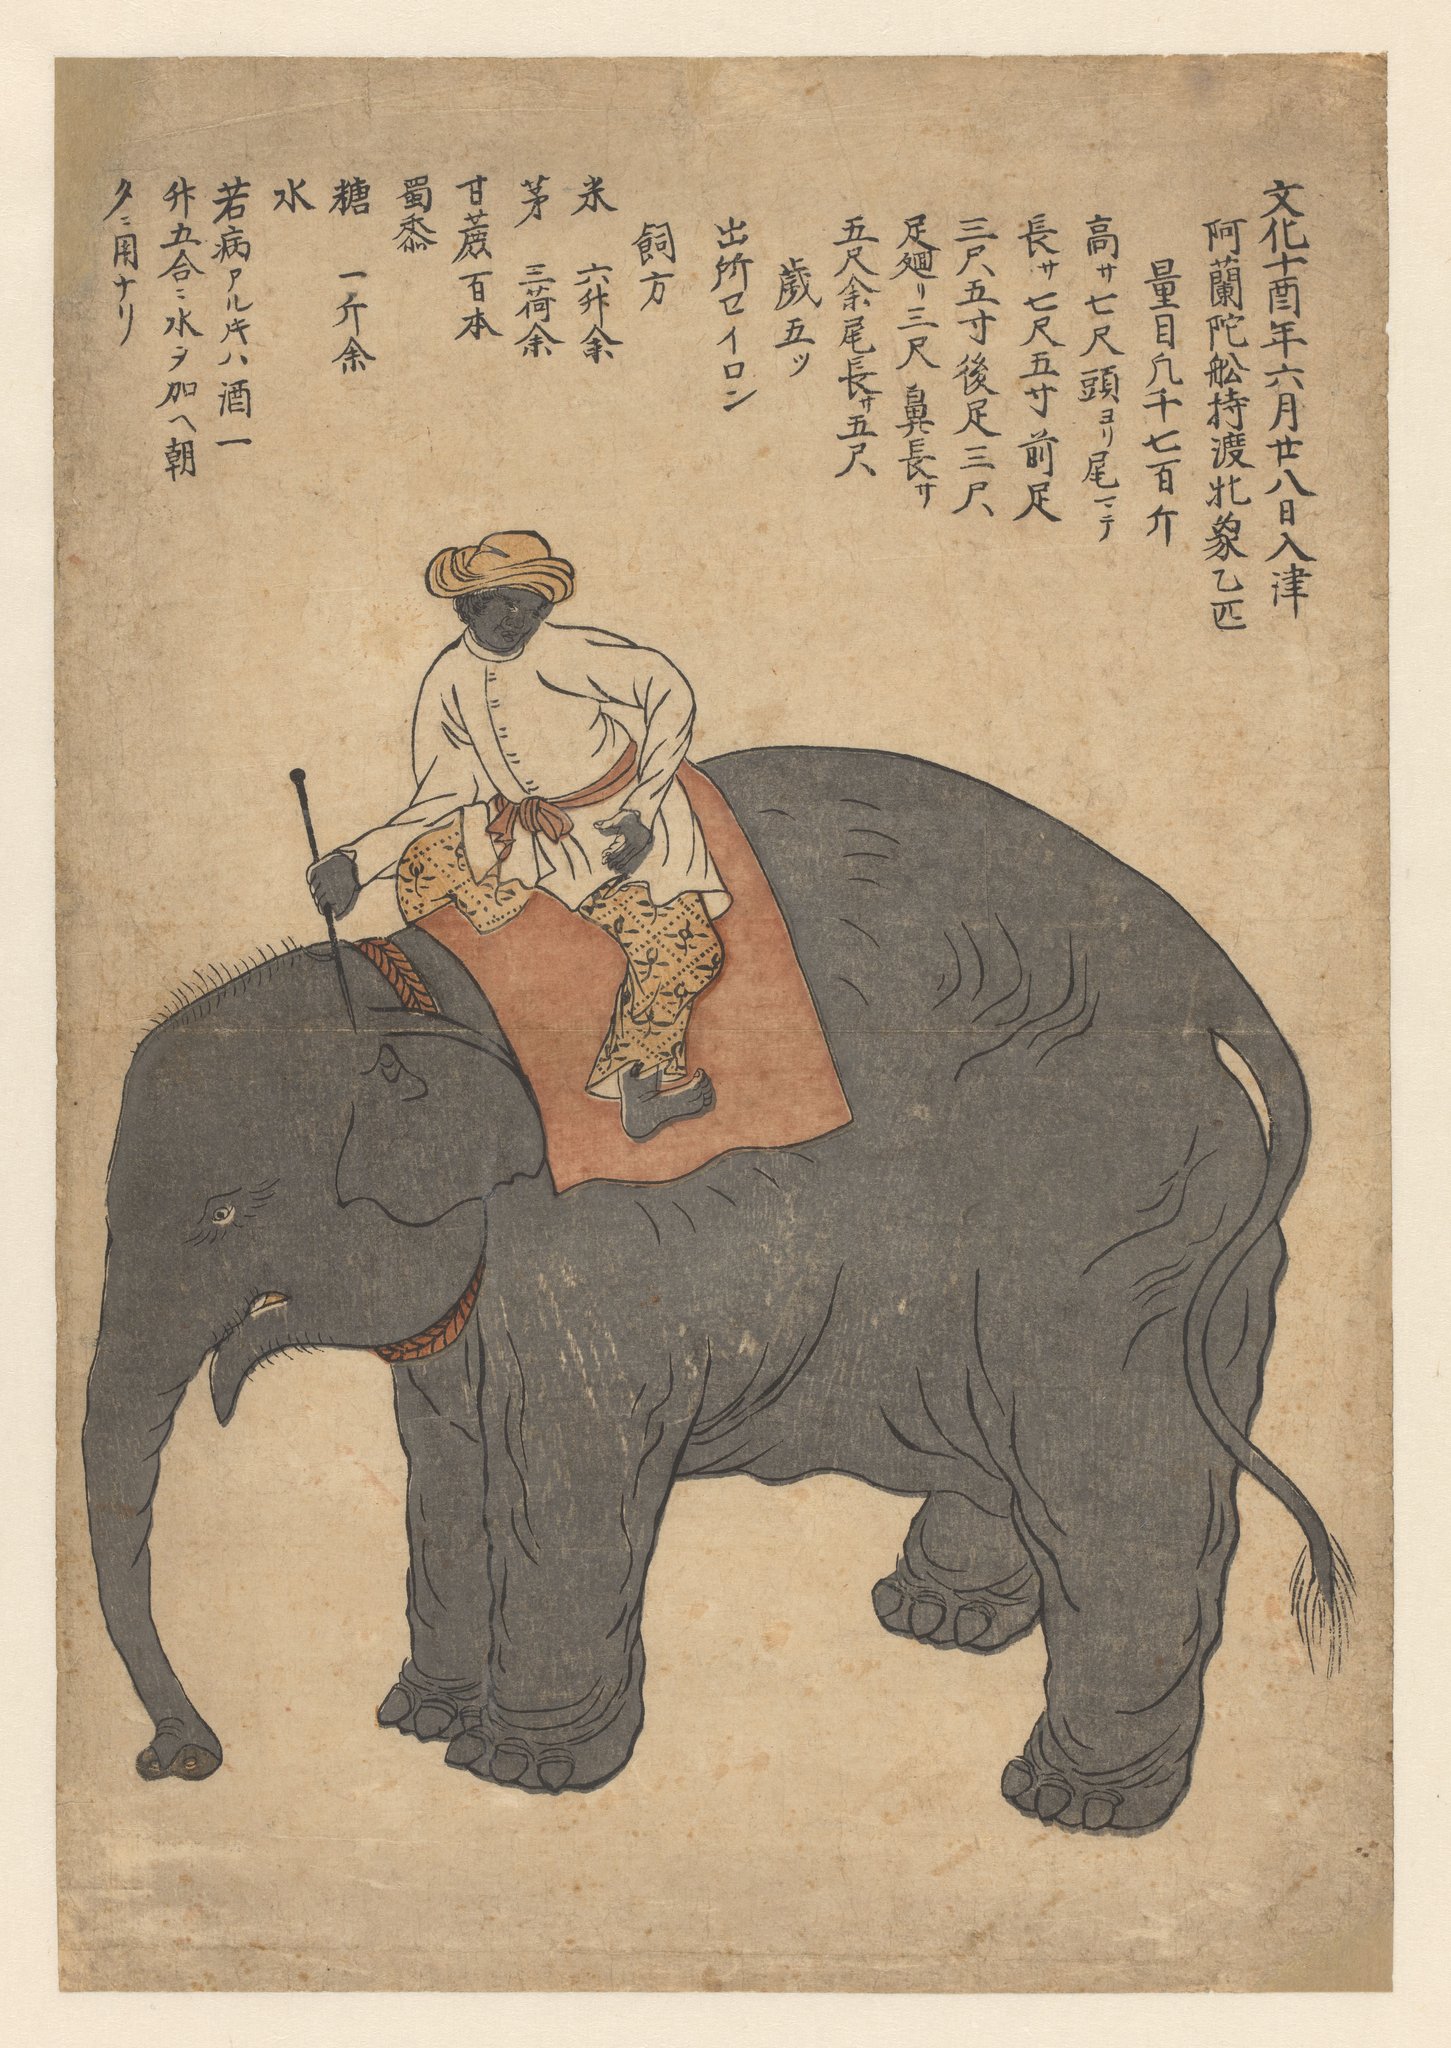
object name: print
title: Olifant gebracht door een Nederlands schip in 1813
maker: Anonymous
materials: paper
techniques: woodcut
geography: nagasaki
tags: trunked animals: elephant, japan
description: Afbeelding van een olifant met berijder. Een zogenaamde 'Nagasaki prent'. De tekst vermeld dat het gaat om de olifant die met een Nederlands schip in 1813 naar Nagasaki werd gebracht.